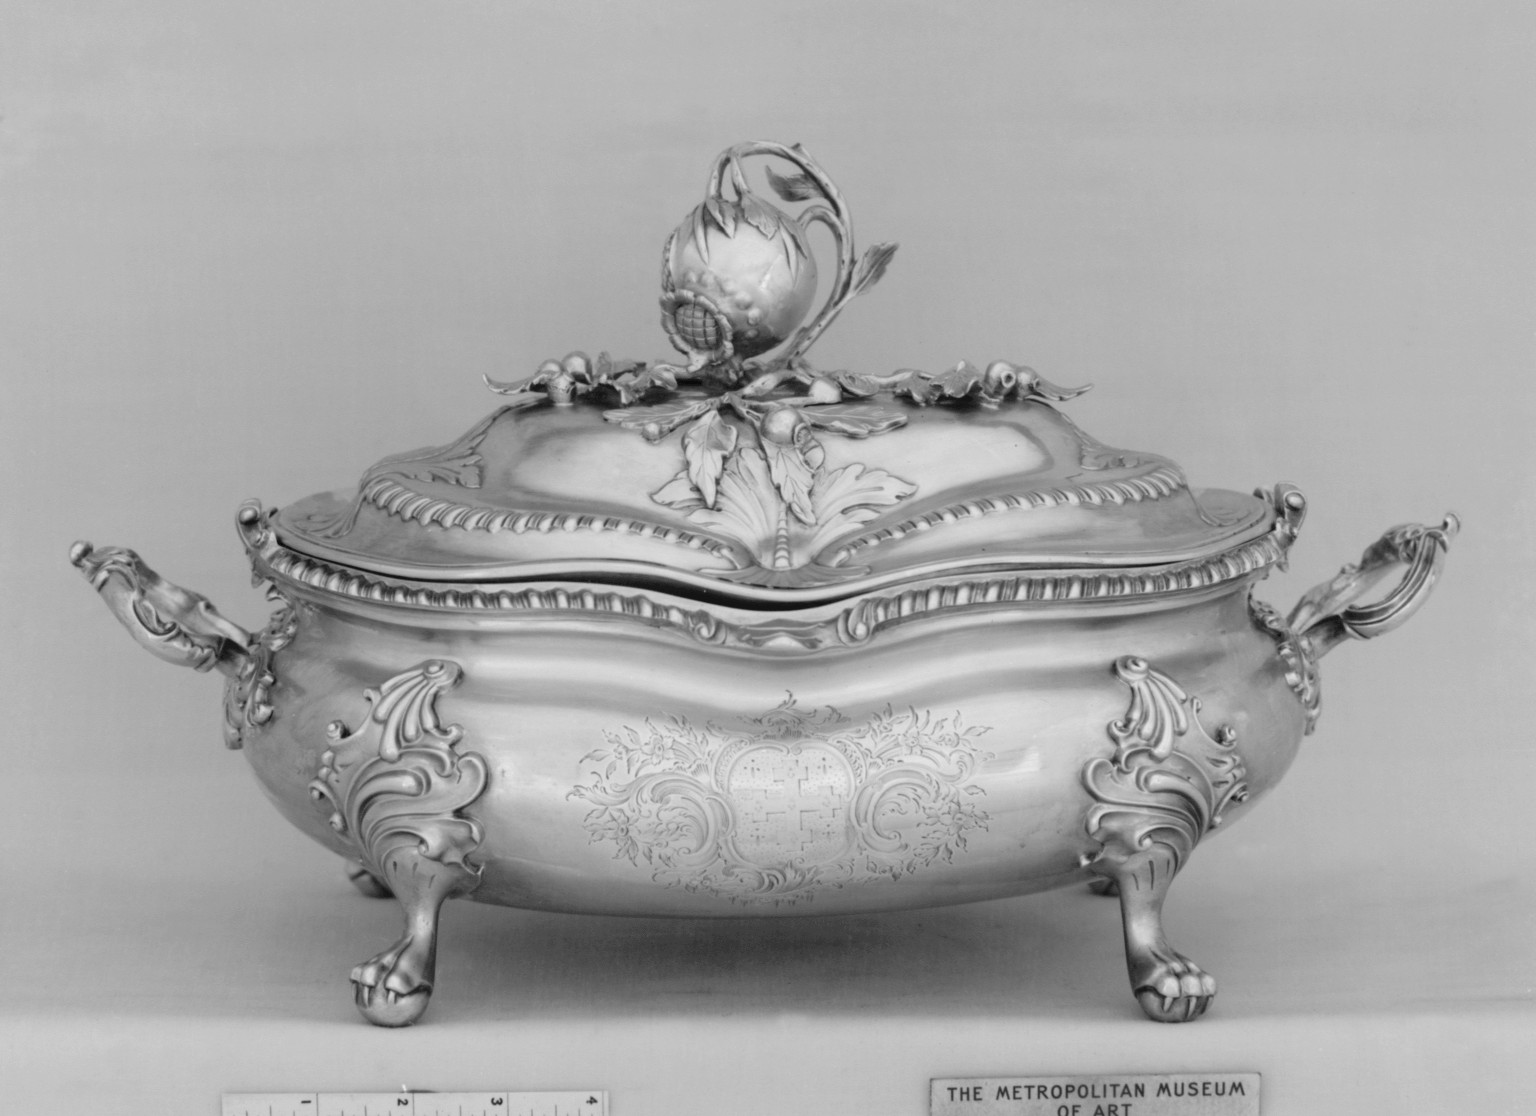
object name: soup tureen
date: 1759-1760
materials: silver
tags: pomegranates,coat of arms